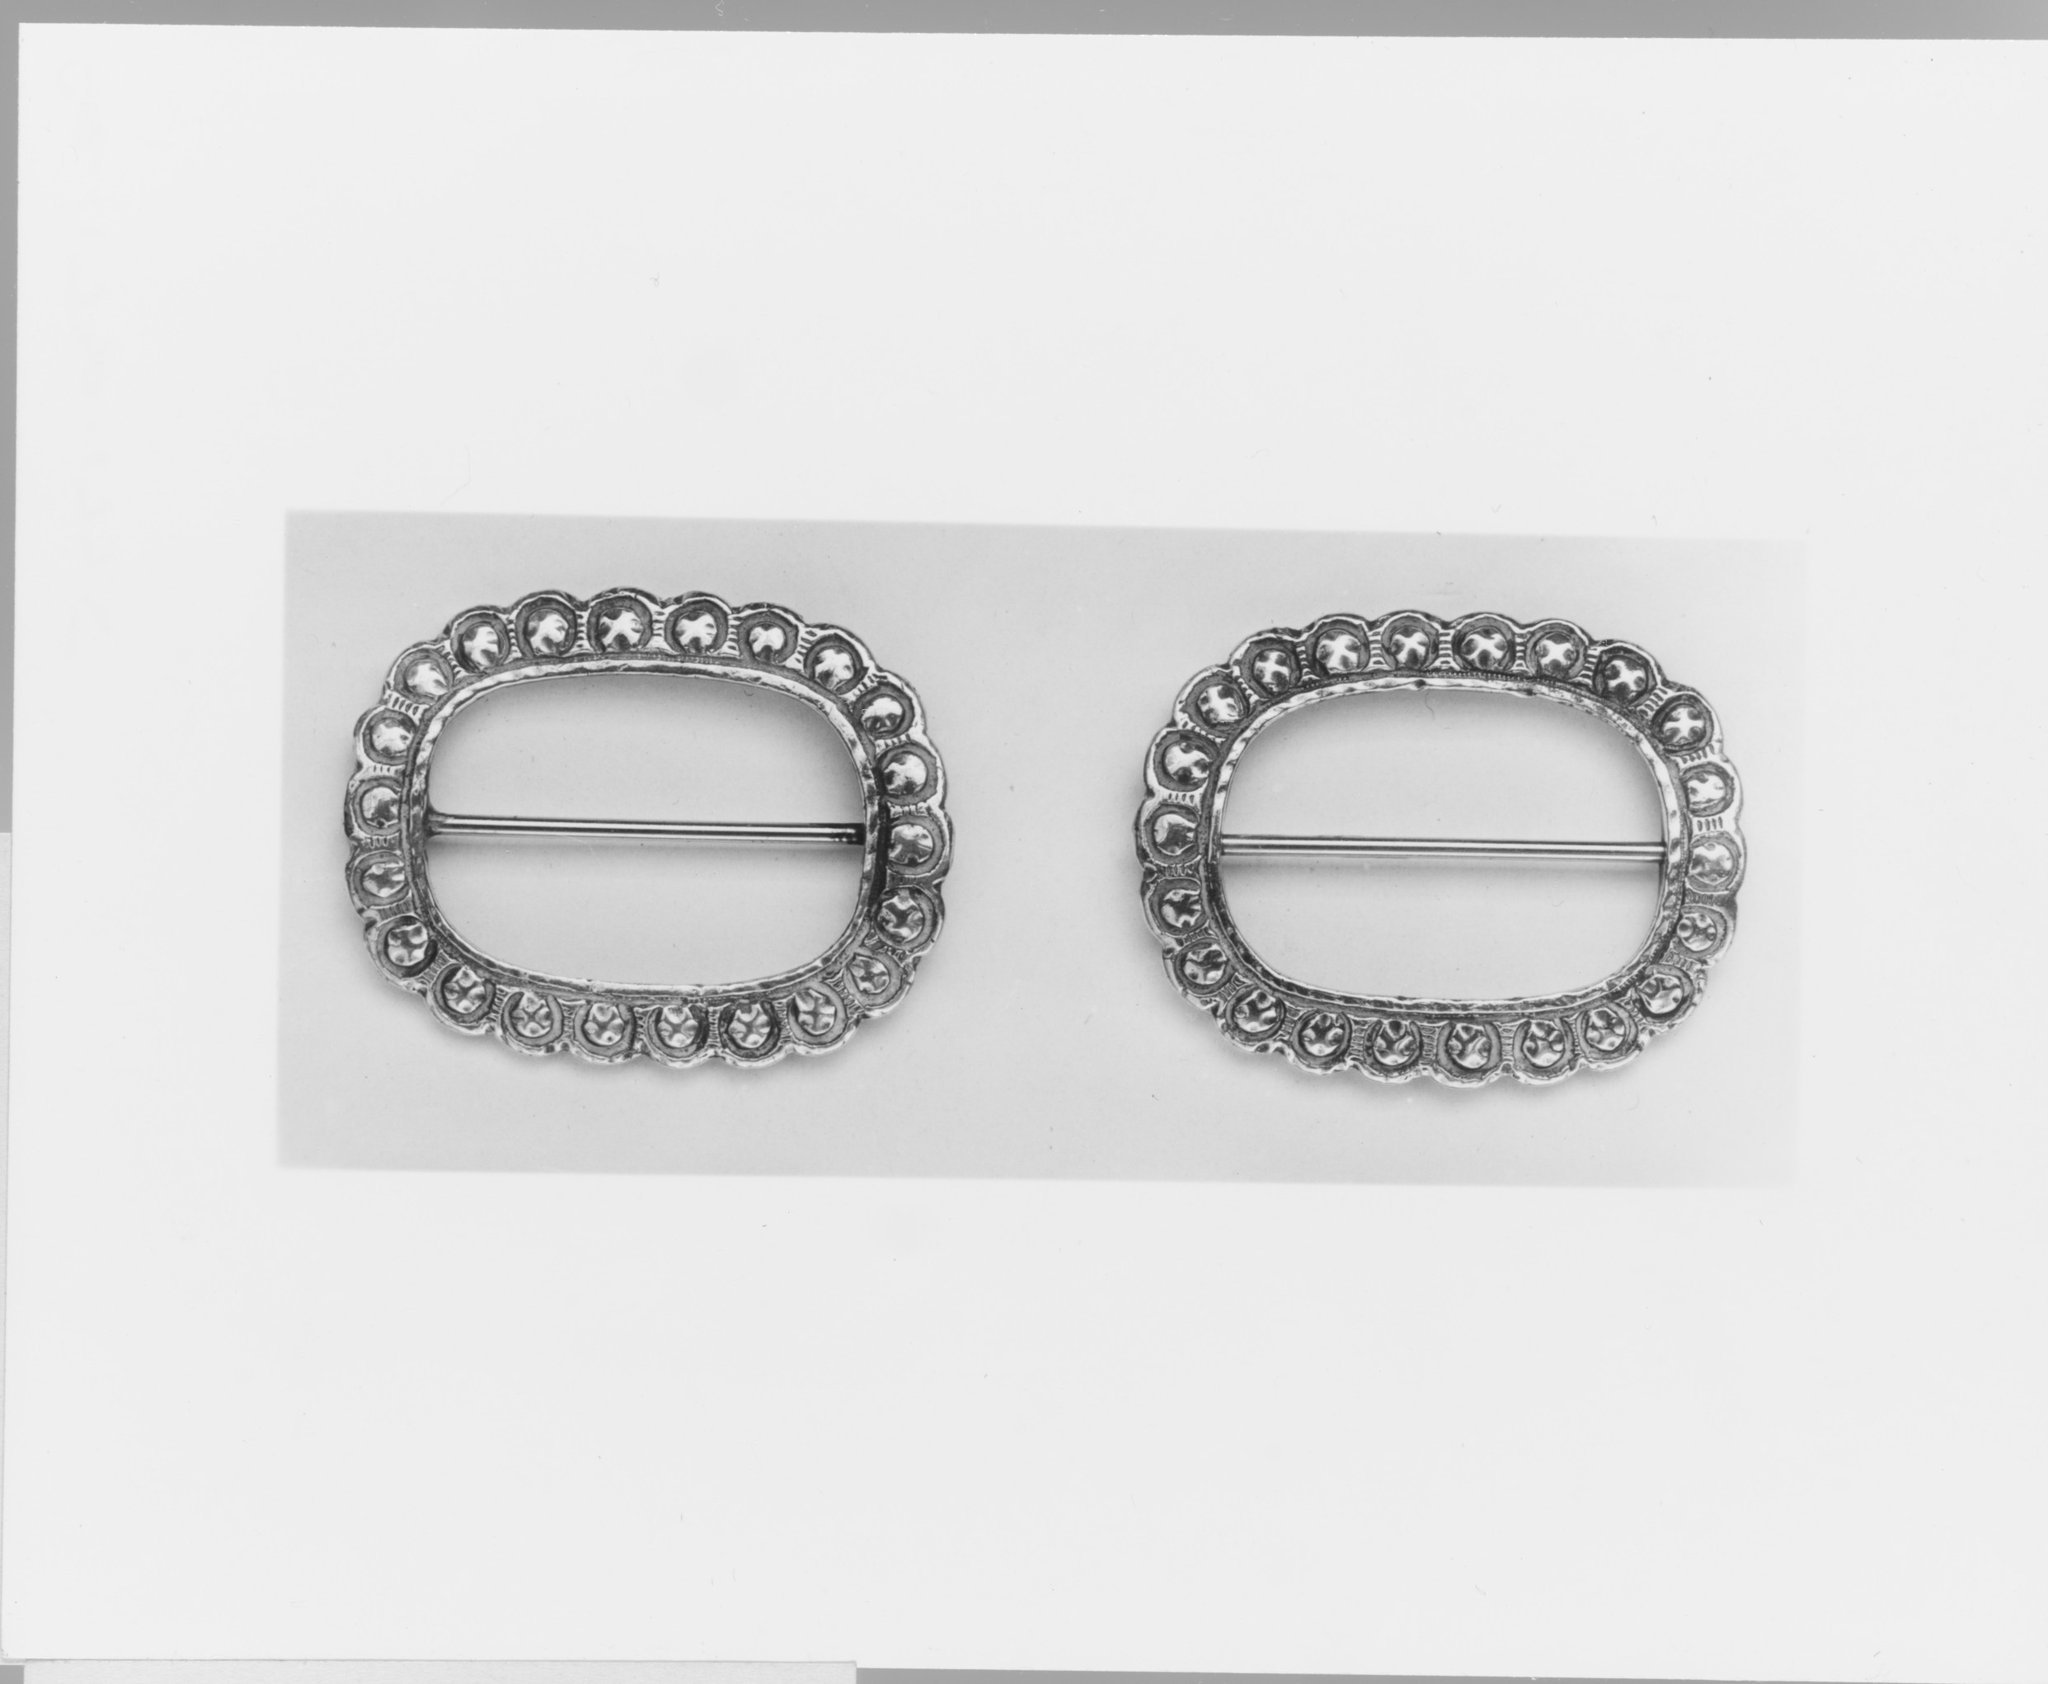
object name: buckle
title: Knee Buckle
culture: american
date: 1730-1775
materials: silver